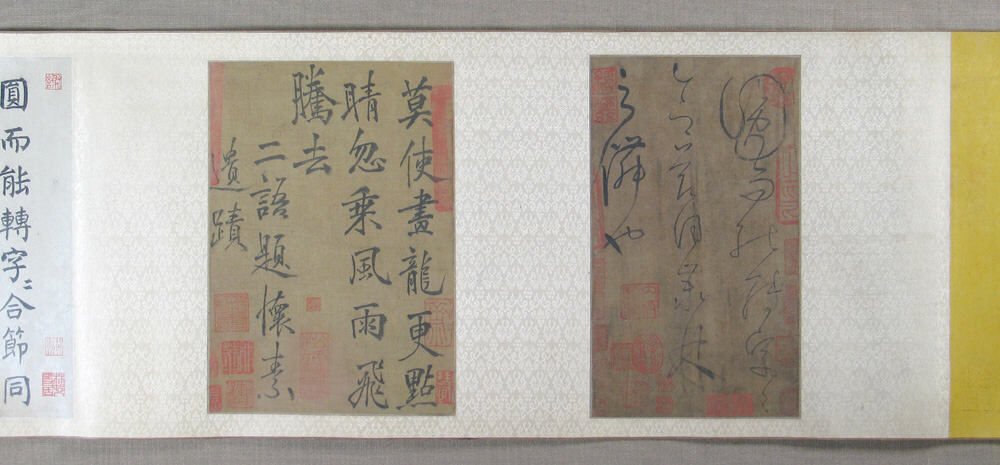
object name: handscroll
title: Calligraphy (Caoshu)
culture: chinese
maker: unidentified artist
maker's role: artist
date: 1368-1911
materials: ink, paper